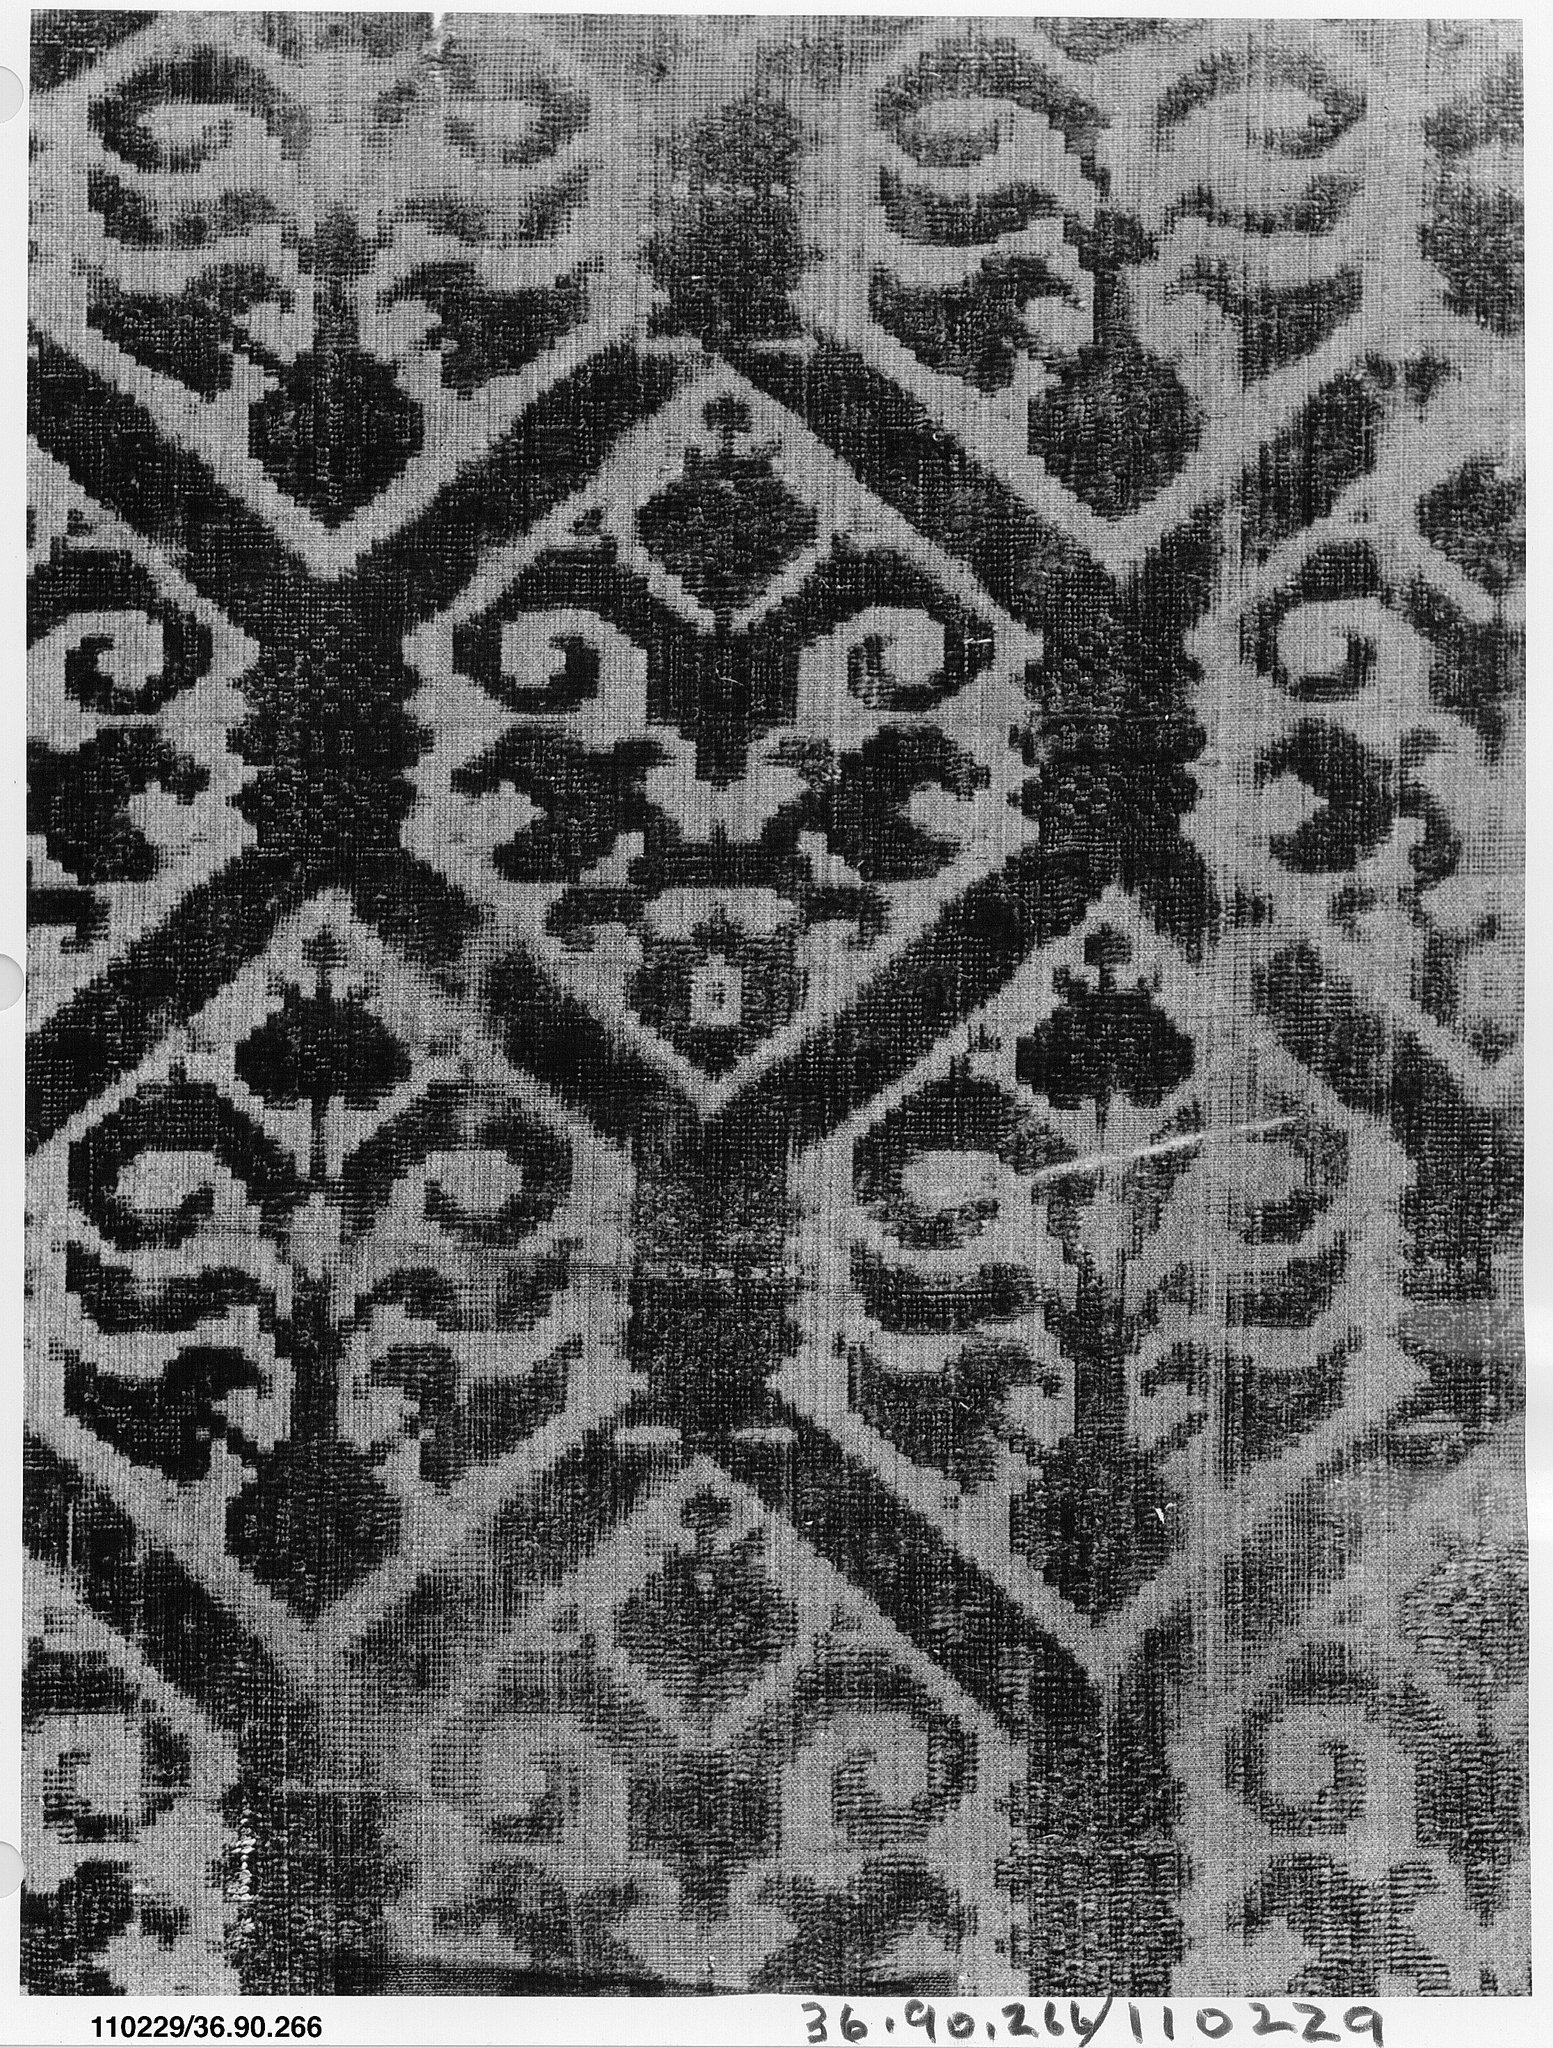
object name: piece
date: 1501-1700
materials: silk